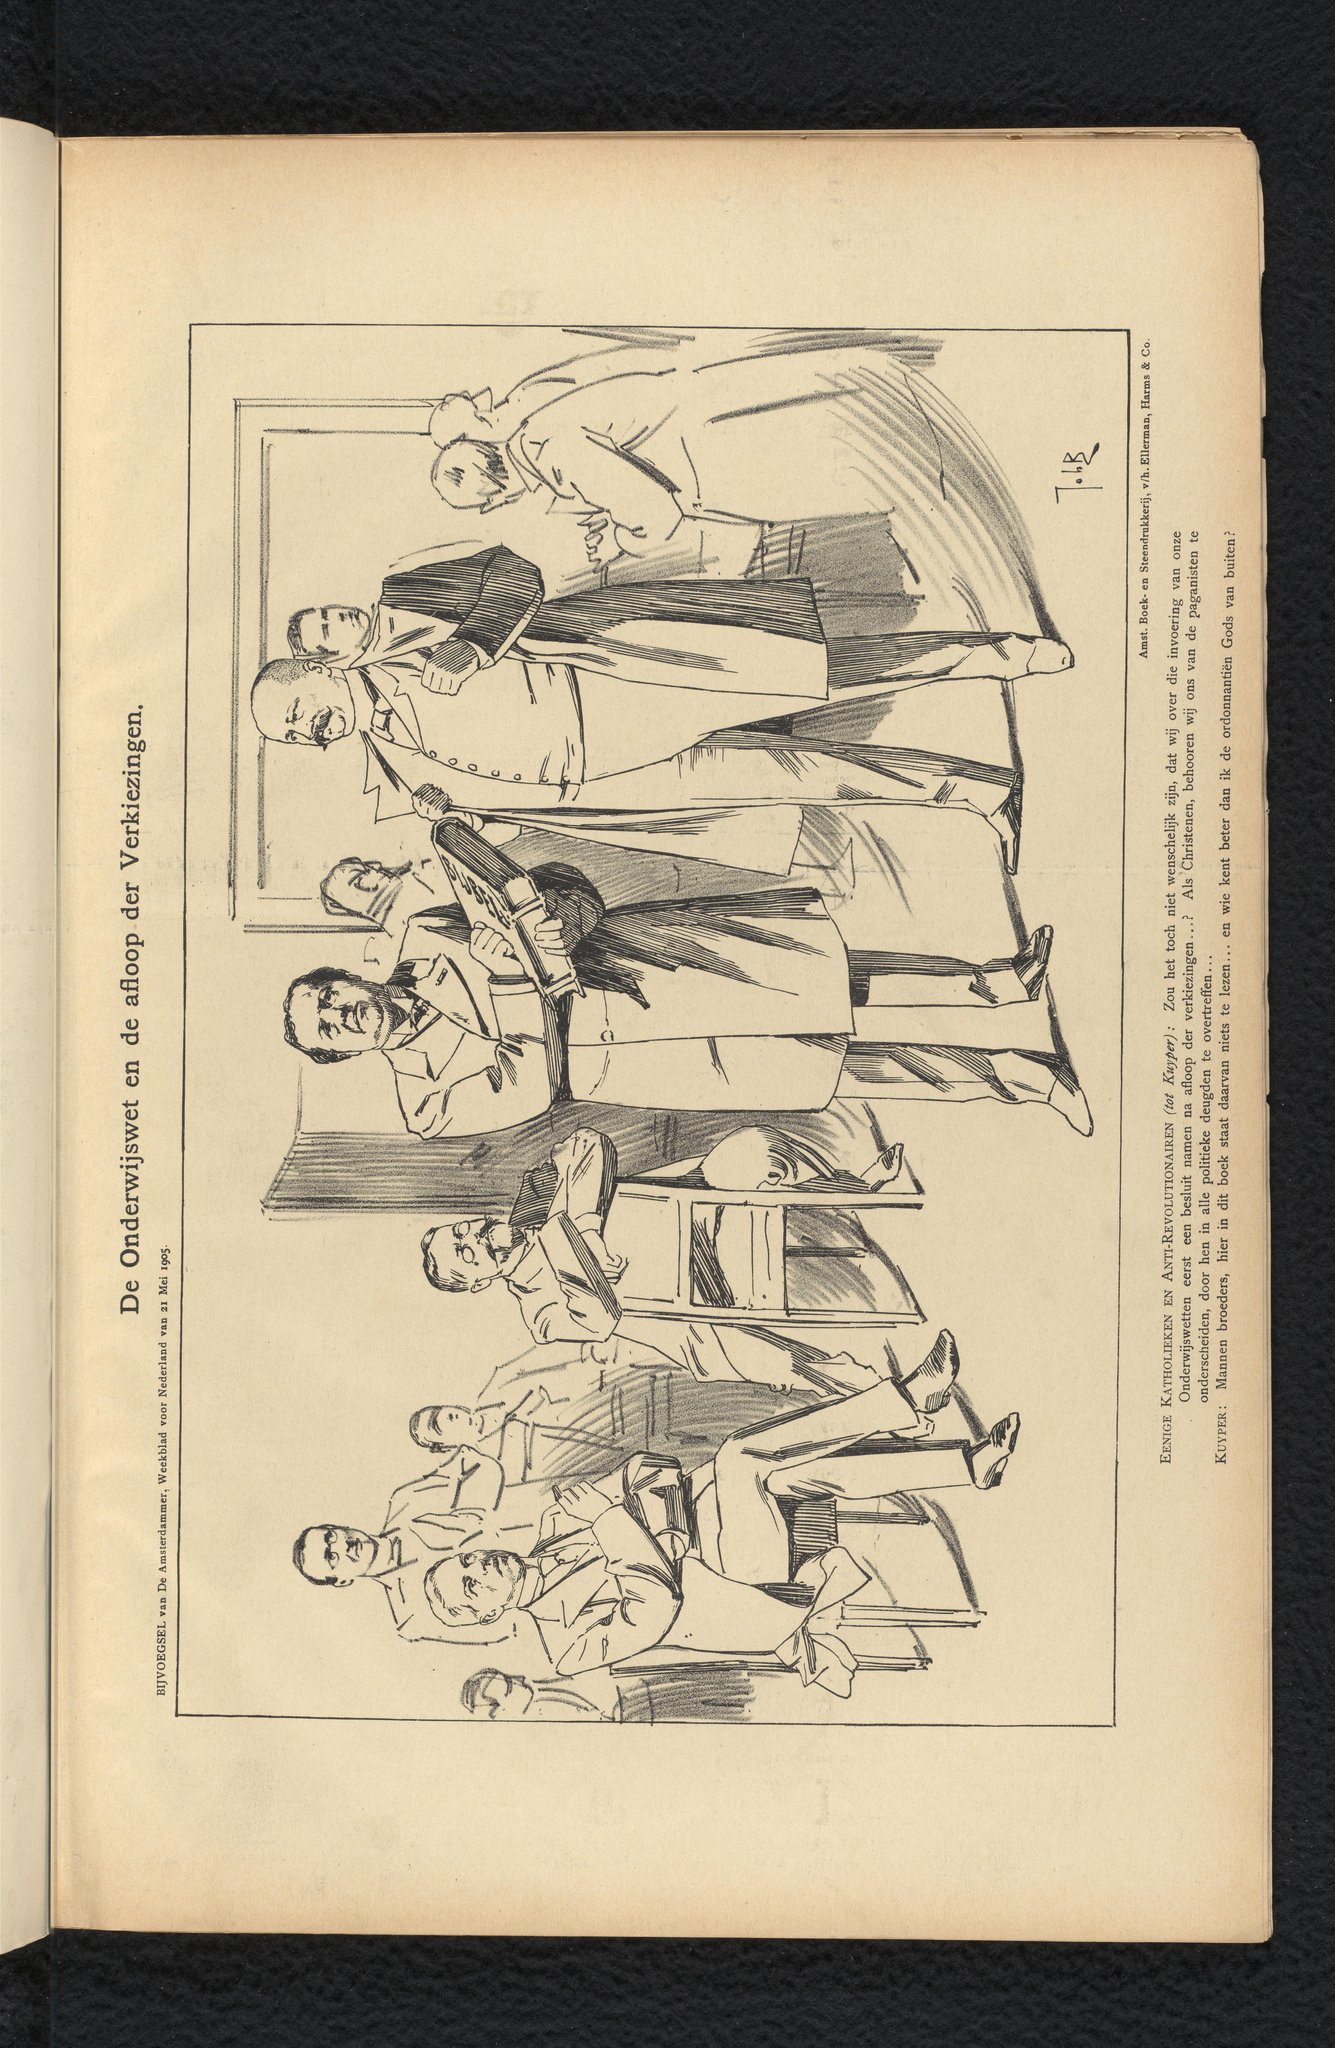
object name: cartoon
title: De Onderwijswet en de afloop der Verkiezingen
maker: johan braakensiek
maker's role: draughtsman, print maker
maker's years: 1858-1940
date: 1905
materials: paper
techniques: lithograph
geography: netherlands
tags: the hague, abraham kuyper, member of parliament, political caricatures and satires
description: Premier Kuyper met de Bijbel in de hand staande tussen confessionele Kamerleden (mannenbroeders), over de wet op het lager onderwijs.